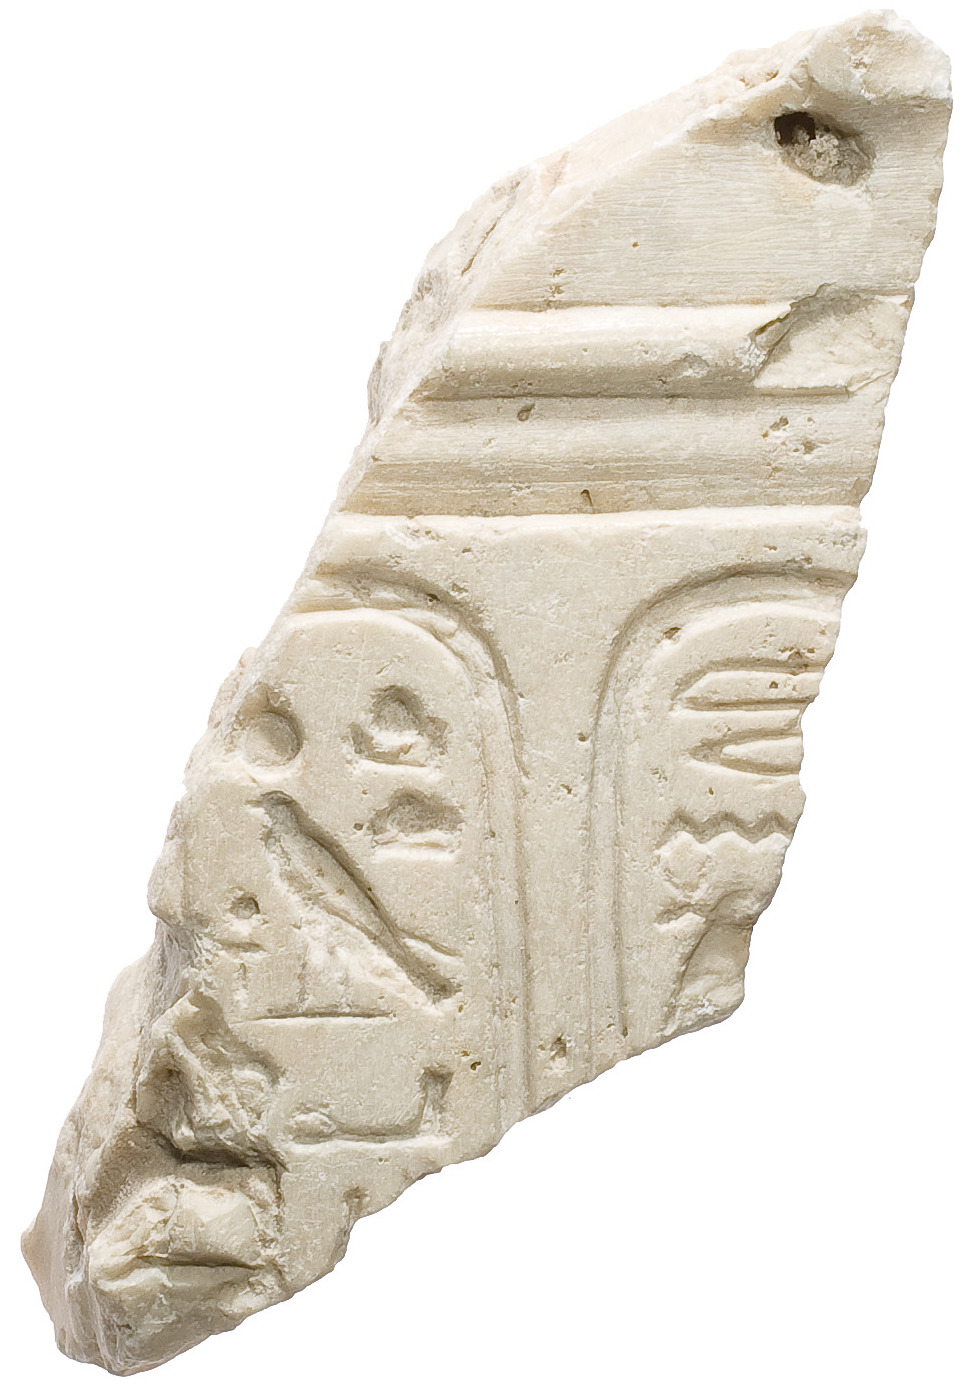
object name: inscribed balustrade or stela element, aten cartouch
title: Inscribed balustrade or stela element, Aten cartouches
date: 1353-1336 BCE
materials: limestone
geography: egypt